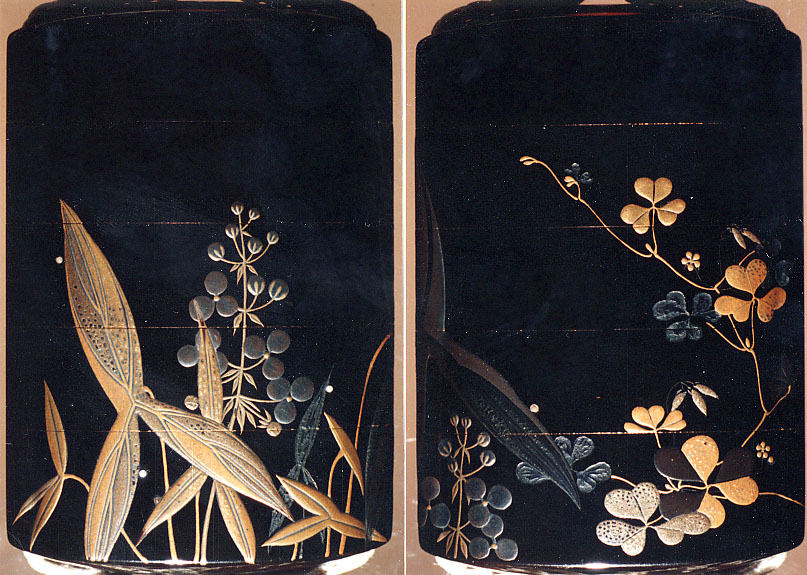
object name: inrō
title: Case (Inrō) with Design of Arrowhead (Omodaka) (obverse); Clover (Mutsuba) (reverse)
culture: japanese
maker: shibata zeshin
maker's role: artist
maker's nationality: japanese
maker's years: 1807-1891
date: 1801-1900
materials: gold, lacquer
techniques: fundame, hiramakie, roiro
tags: flowers